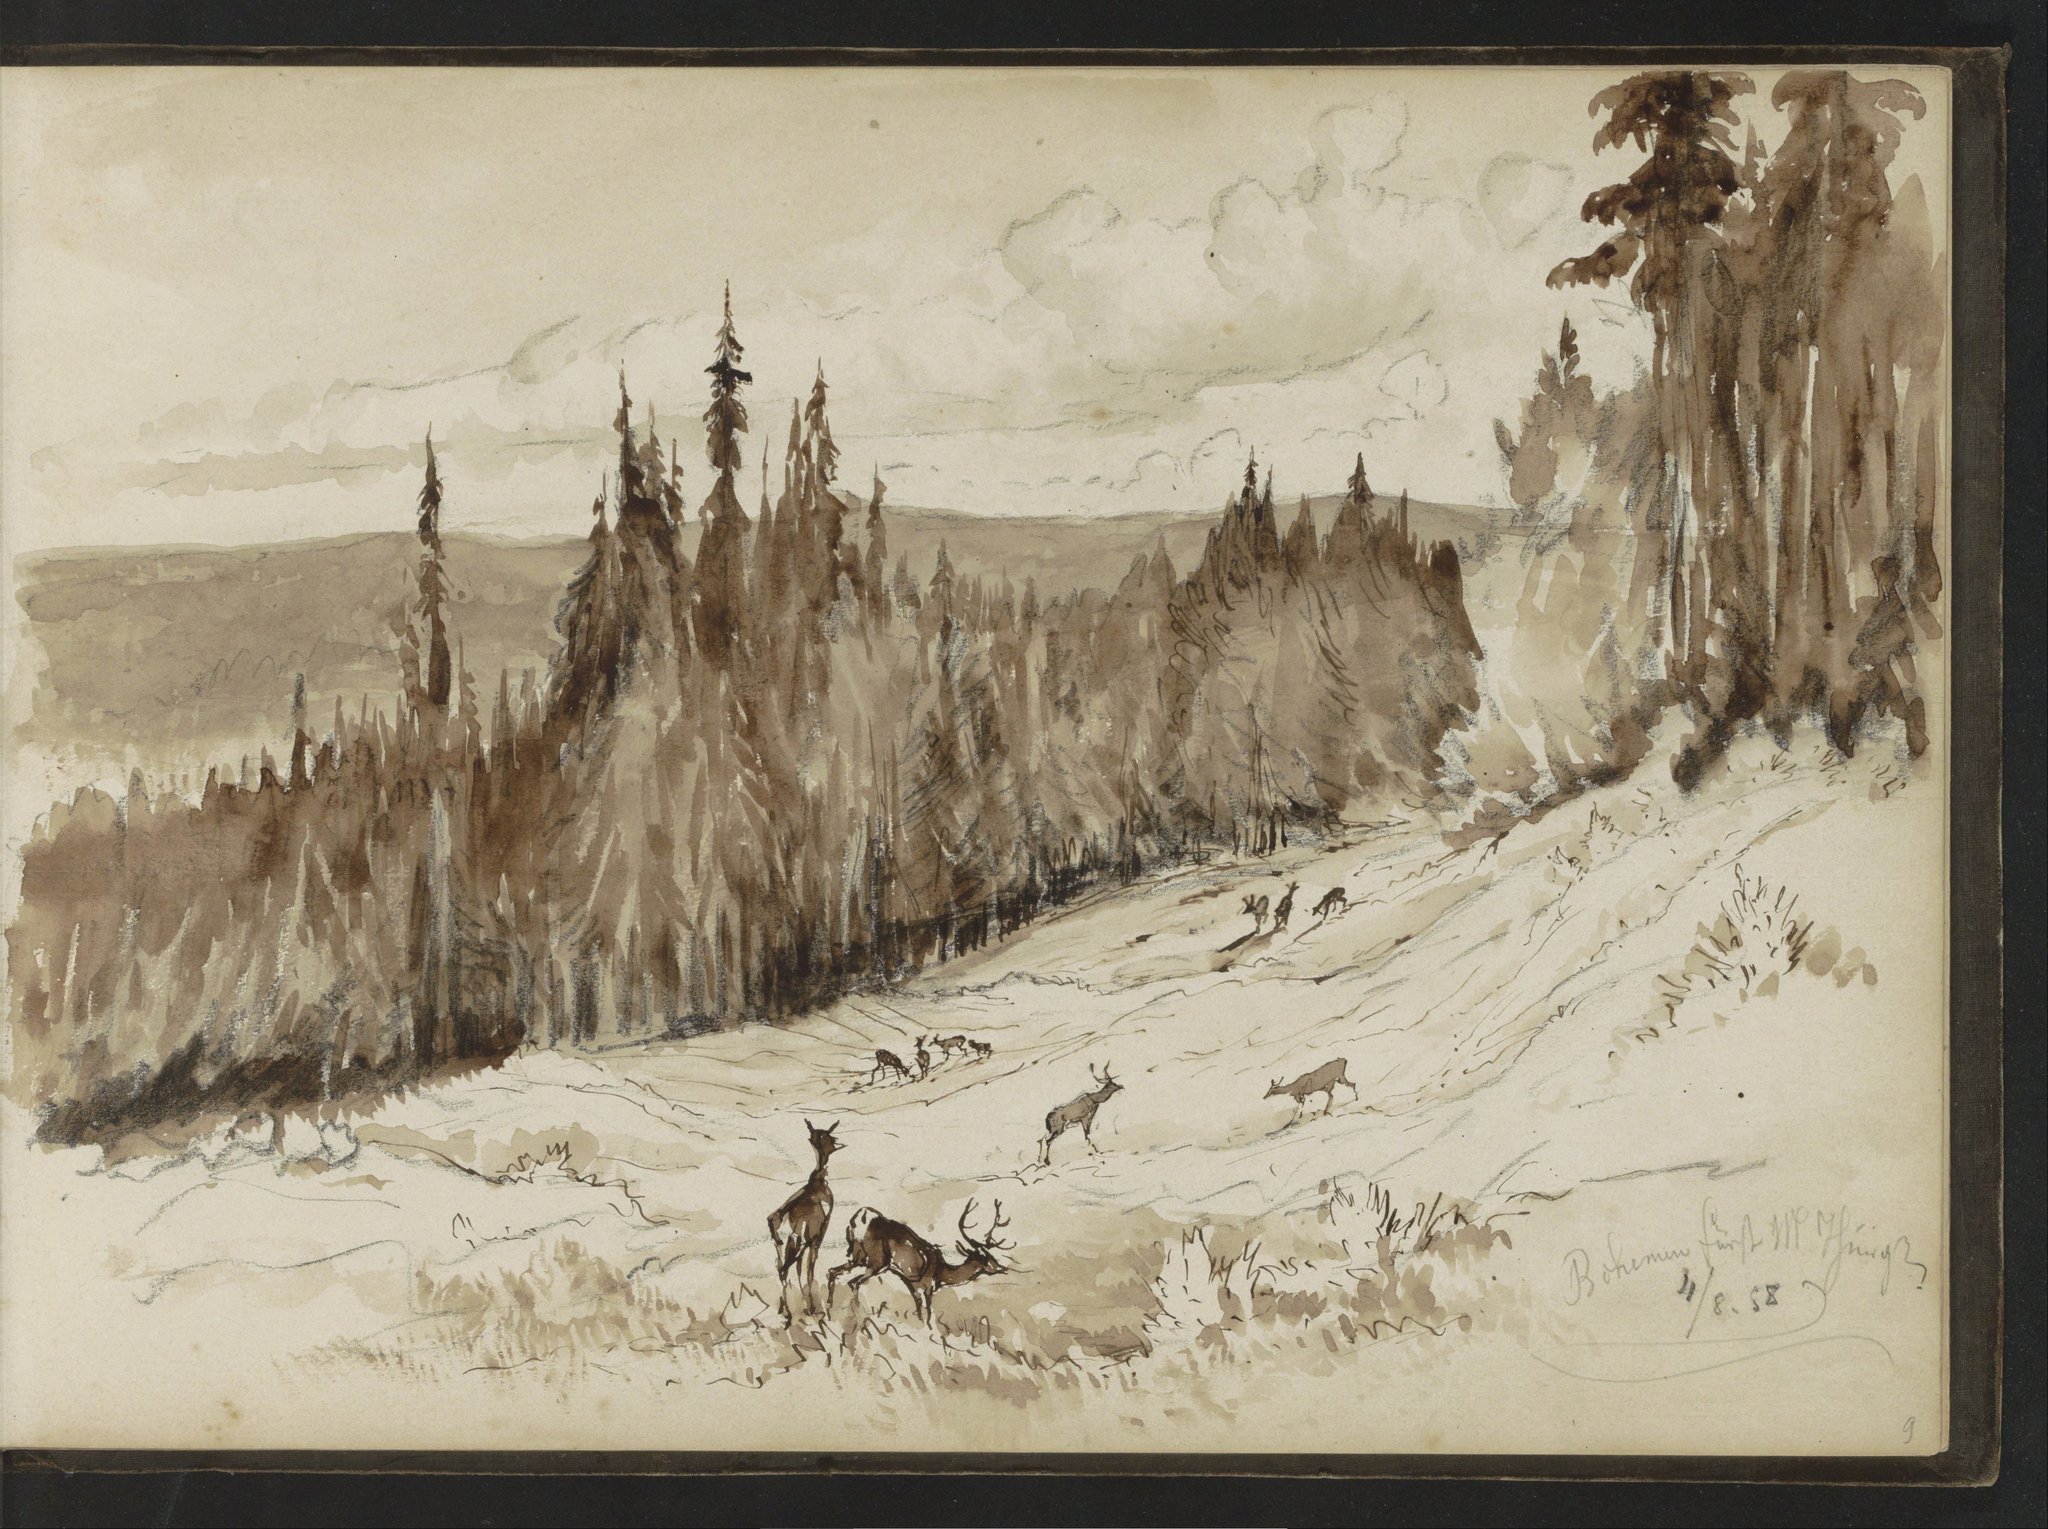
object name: sketchbook leaf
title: Berglandschap met herten in Bohemen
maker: johannes tavenraat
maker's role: draughtsman, painter, print maker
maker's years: 1809-1881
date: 1808-1858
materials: paper, pencil, watercolor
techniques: brush, pen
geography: bohemia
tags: hoofed animals: deer, forest, wood, mountains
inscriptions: date and inscription: ‘Bohemen fürst [...]/ 4/8 58’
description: Blad 9 recto uit een schetsboek met 57 bladen.